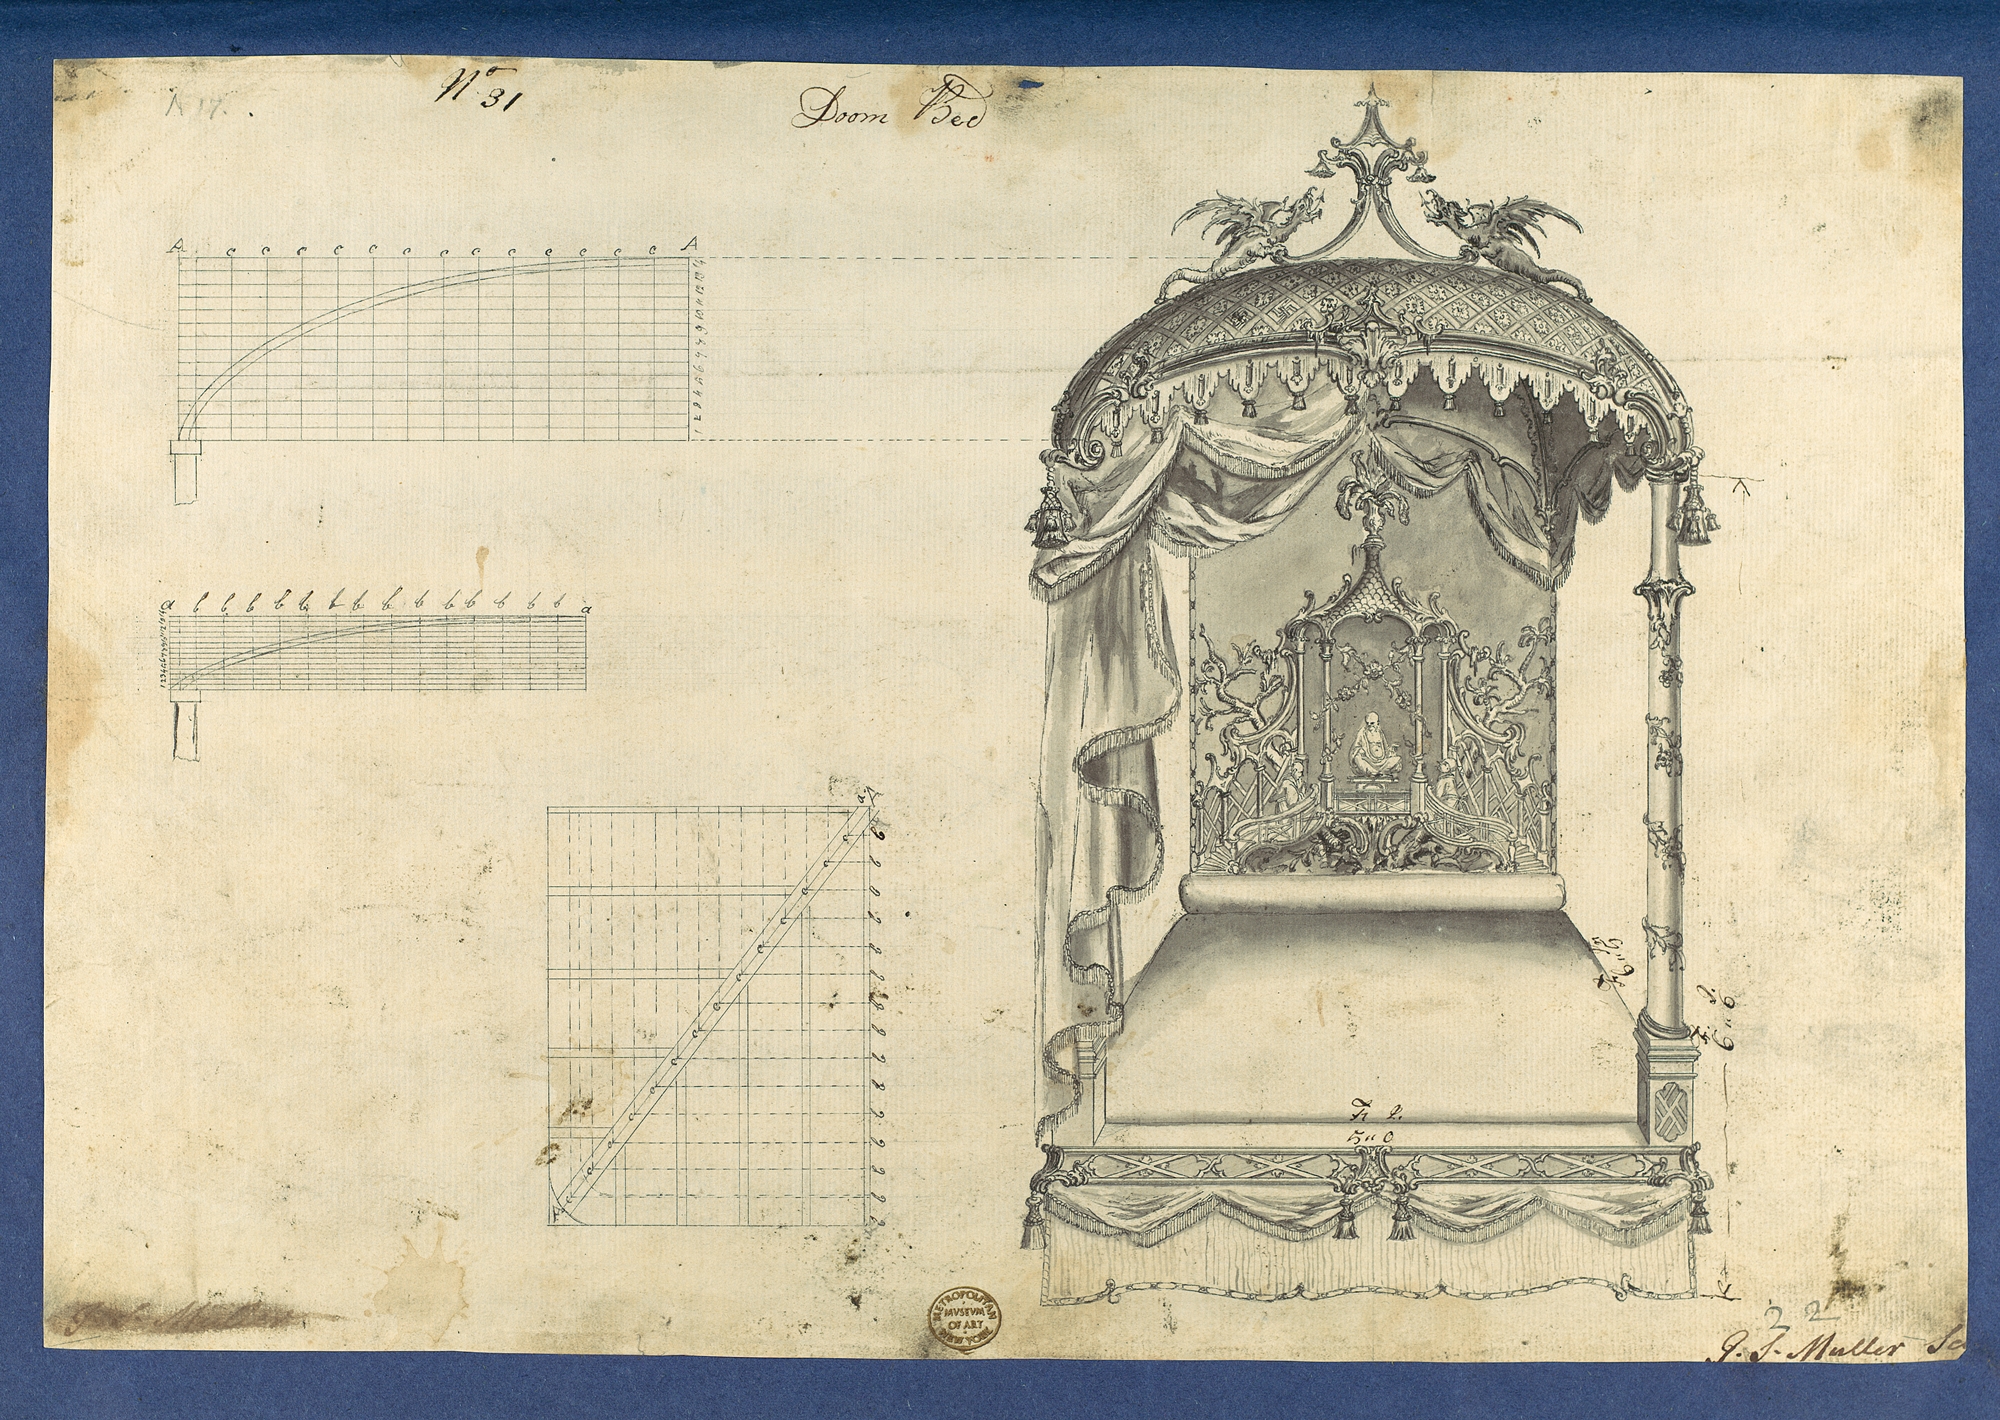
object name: drawing ornament architecture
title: Doom [Dome] Bed, in Chippendale Drawings, Vol. I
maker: thomas chippendale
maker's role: artist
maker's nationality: british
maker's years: 1718-1779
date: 1753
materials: ink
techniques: wash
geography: london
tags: beds